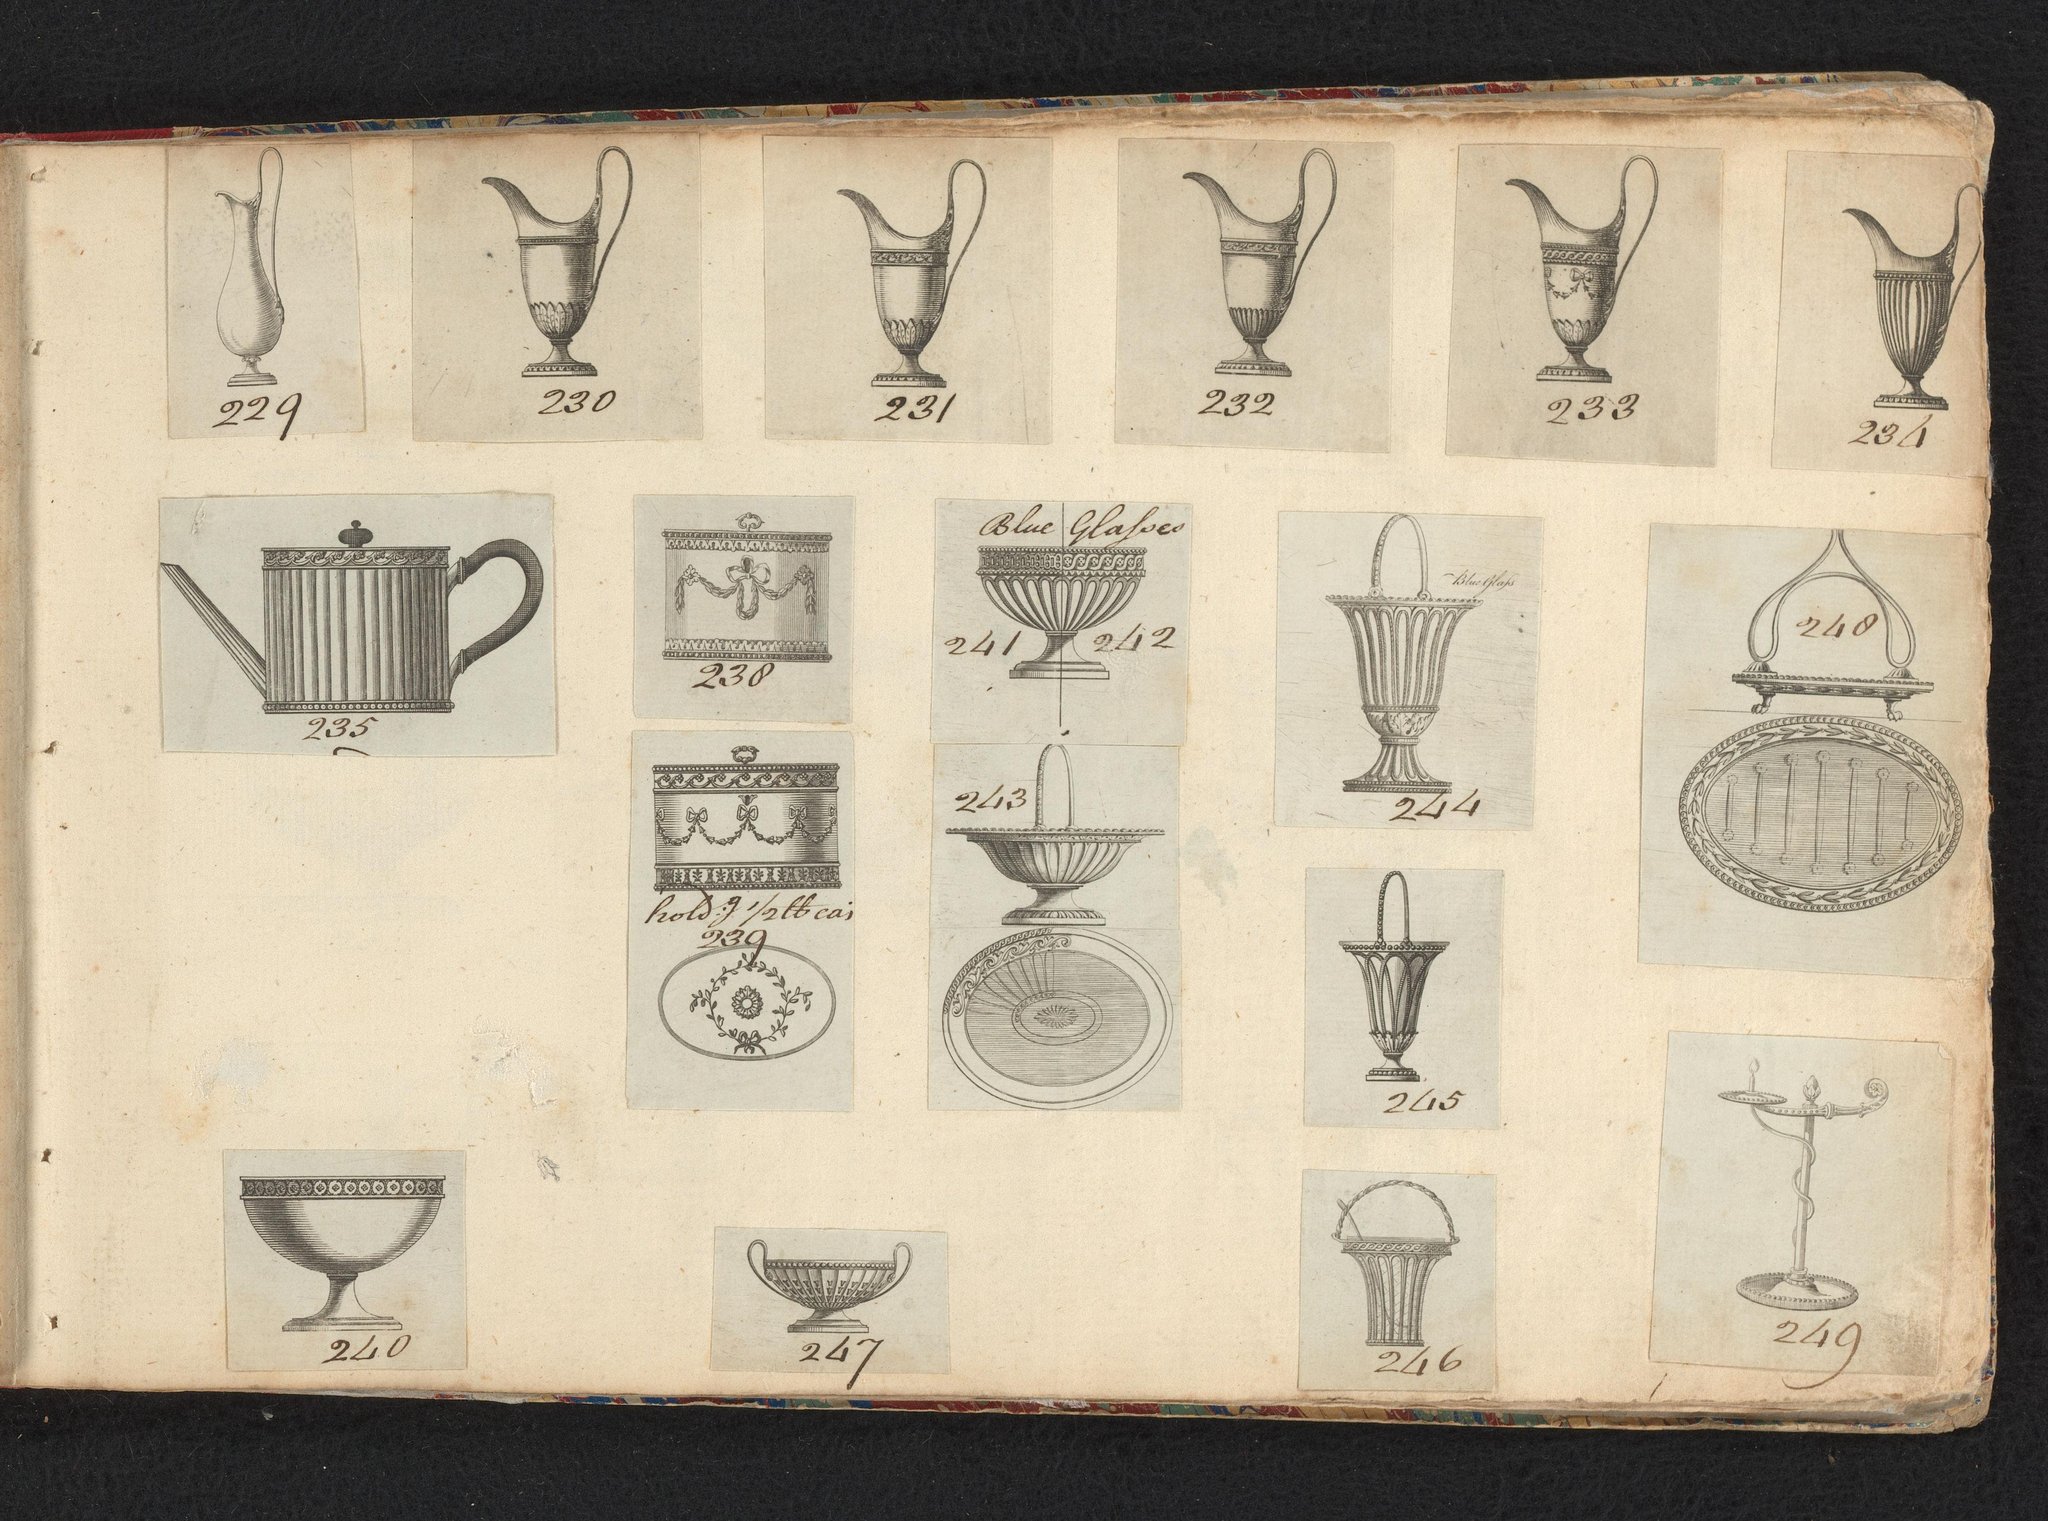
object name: ornament print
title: Ontwerpen voor kannen en schalen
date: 1784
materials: paper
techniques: engraving, etching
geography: england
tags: dinner-service, tea- and coffee-service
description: Blad met achttien ingeplakte bladen met ontwerpen voor kannen, schalen, mandjes en een kandelaar. Met enkele handgeschreven opschriften en nrs. 229-235 en 238-249. Onderdeel van een catalogus met assortiment modellen van Sheffield verzilverd vaatwerk (pleet) door Matthew Boulton.